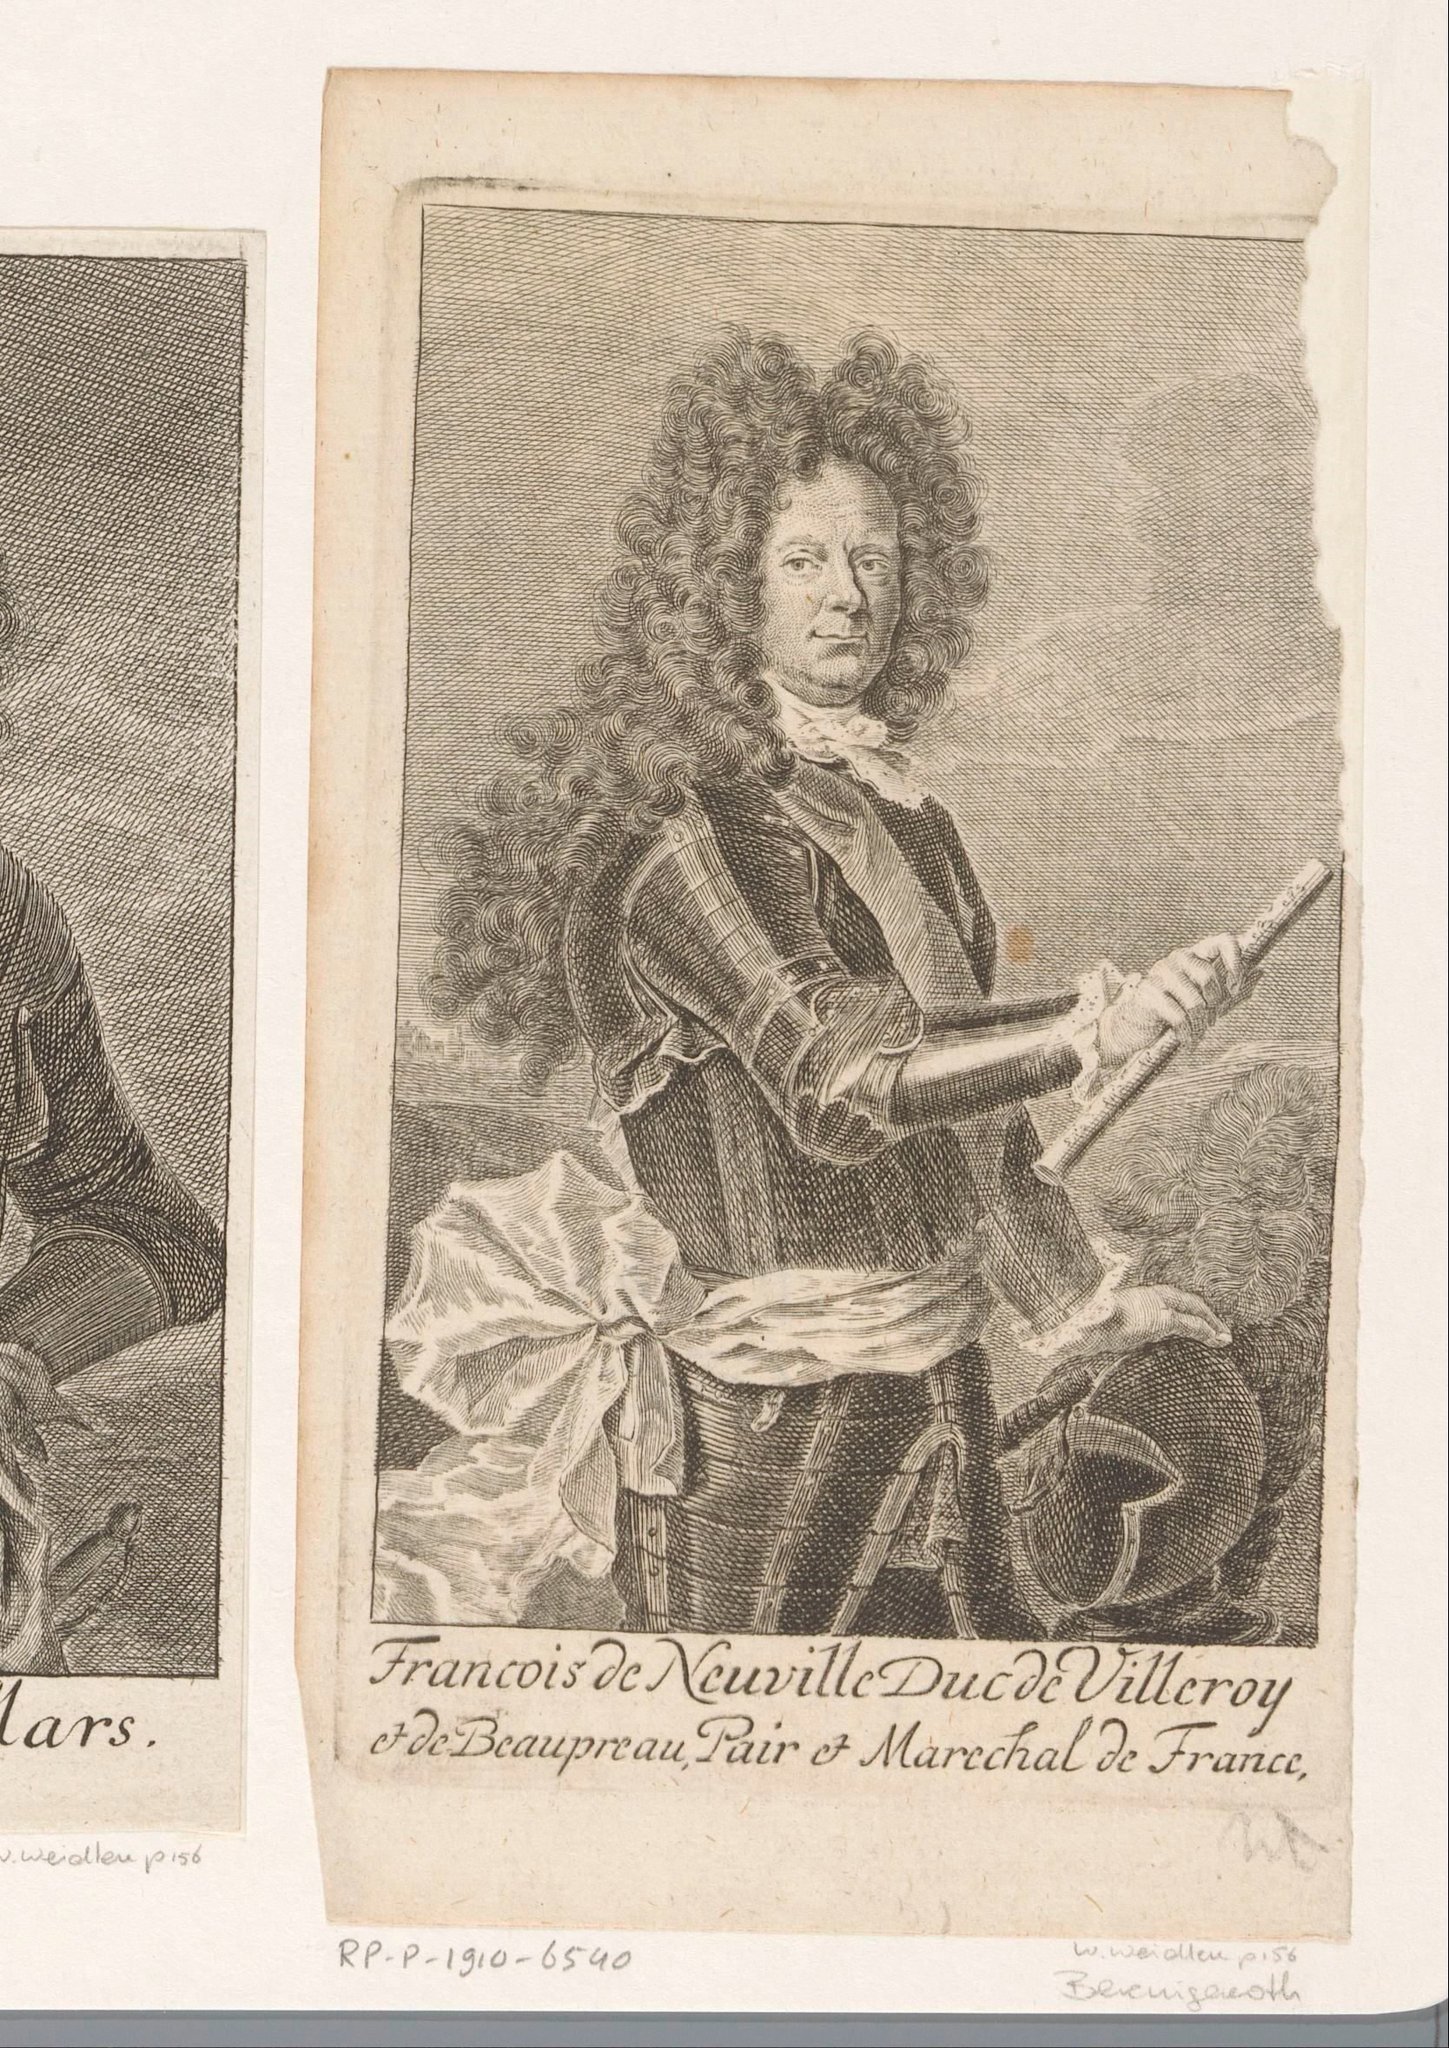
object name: print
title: Portret van François de Neufville de Villeroy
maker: martin bernigeroth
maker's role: print maker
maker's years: 1670-1733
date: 1706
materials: paper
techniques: engraving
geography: leipzig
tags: armour, historical persons, baton of general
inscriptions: collector's mark: Lugt 2228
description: Prent ook gebruikt in: Die Europäische Fama, Welche den gegenwärtigen Zustand der vornehmsten Höfe entdecket. dl. 48. Leipzig: Gleditsch, 1706.